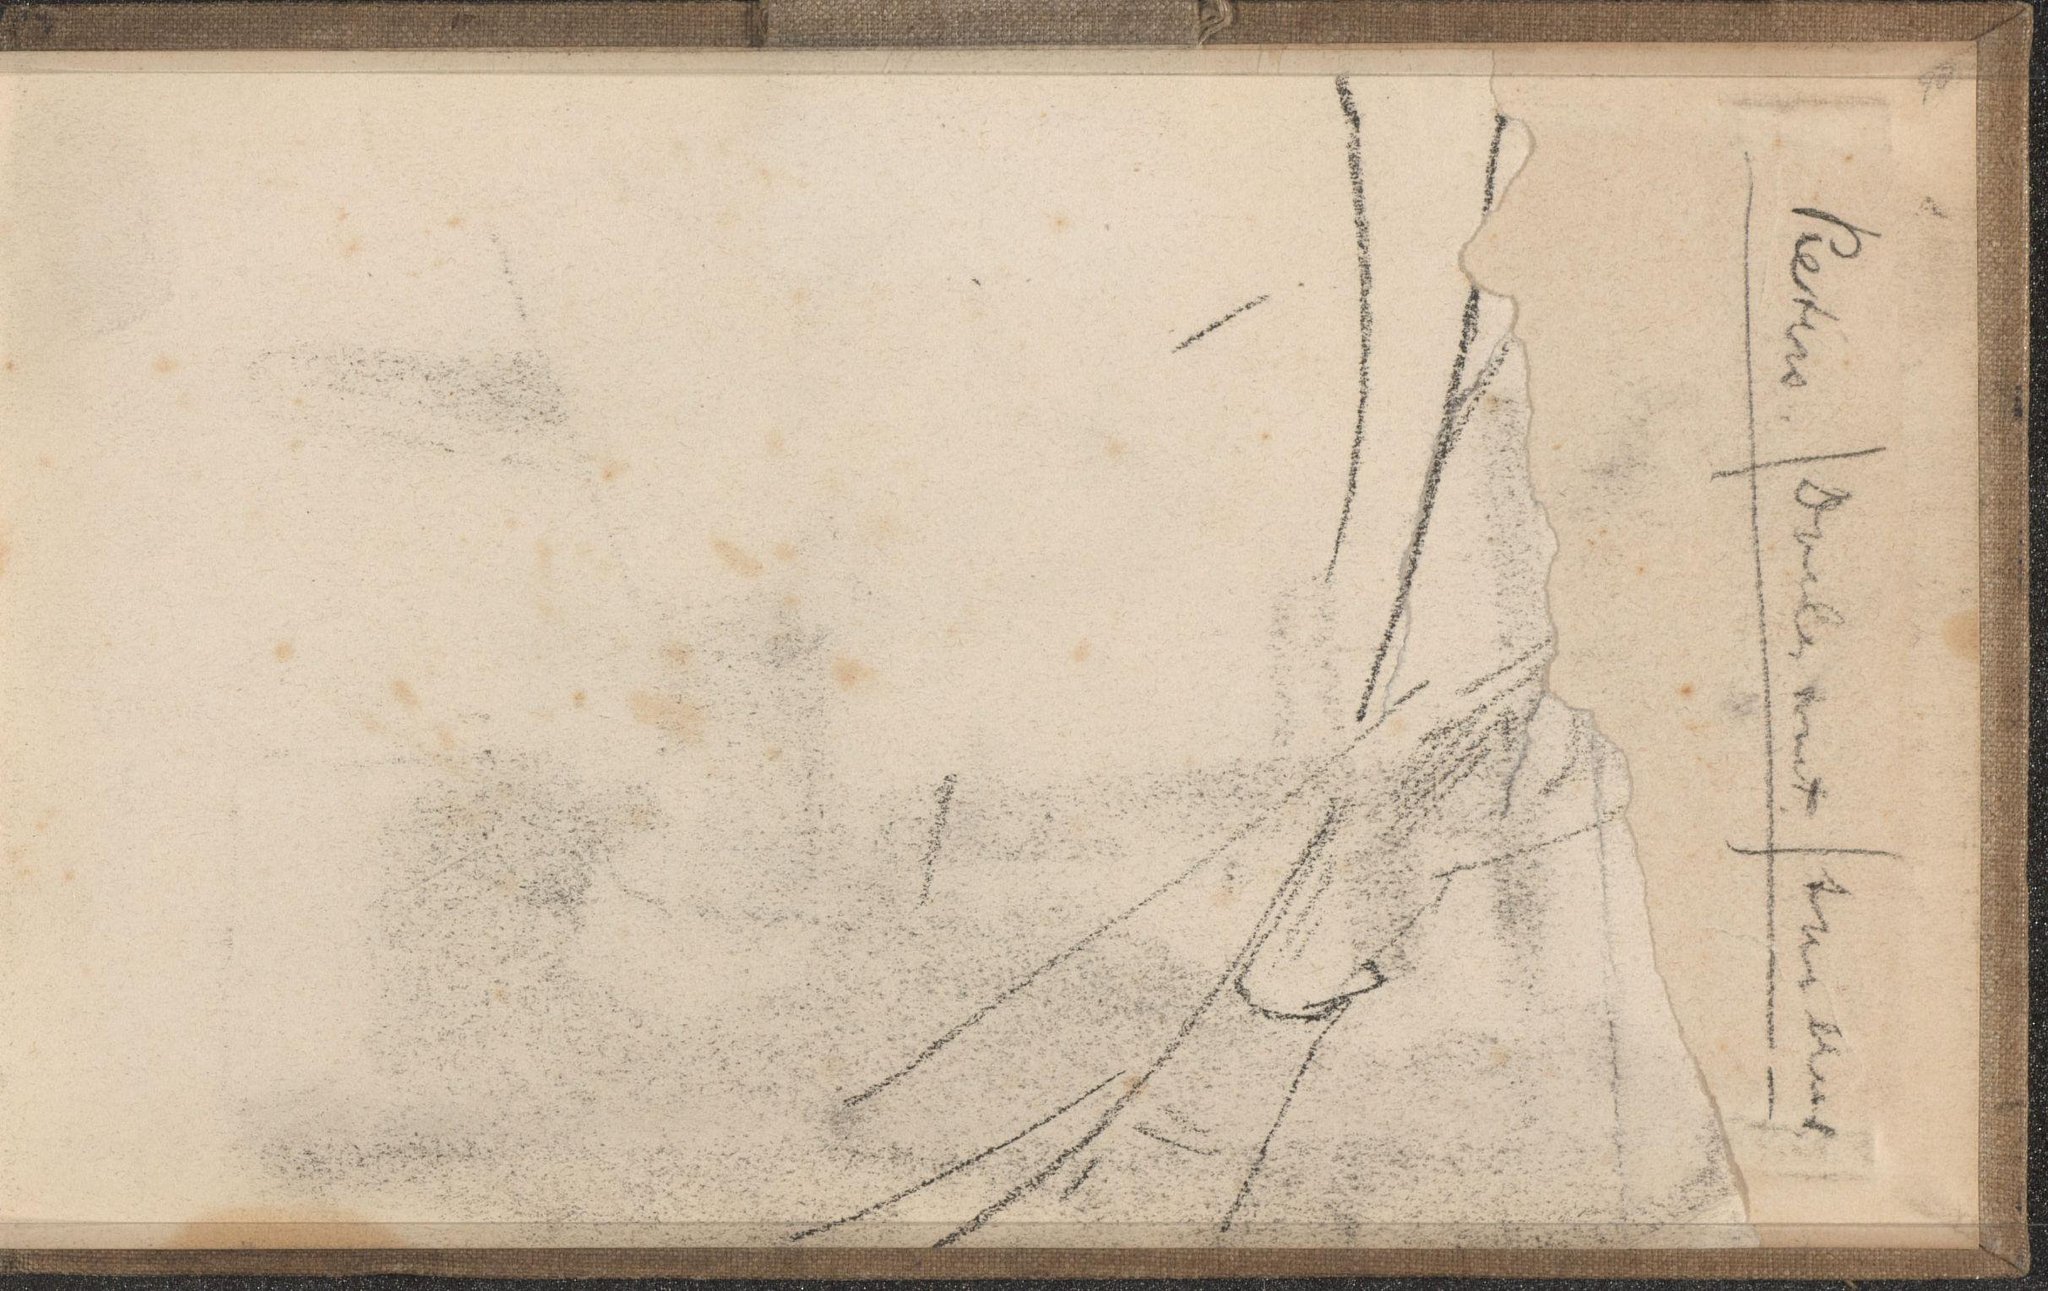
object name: sketchbook leaf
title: Studie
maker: george hendrik breitner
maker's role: draughtsman, painter, print maker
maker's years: 1857-1923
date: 1883-1885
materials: chalk, paper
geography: drenthe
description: Pagina 96 uit een schetsboek met 48 bladen.